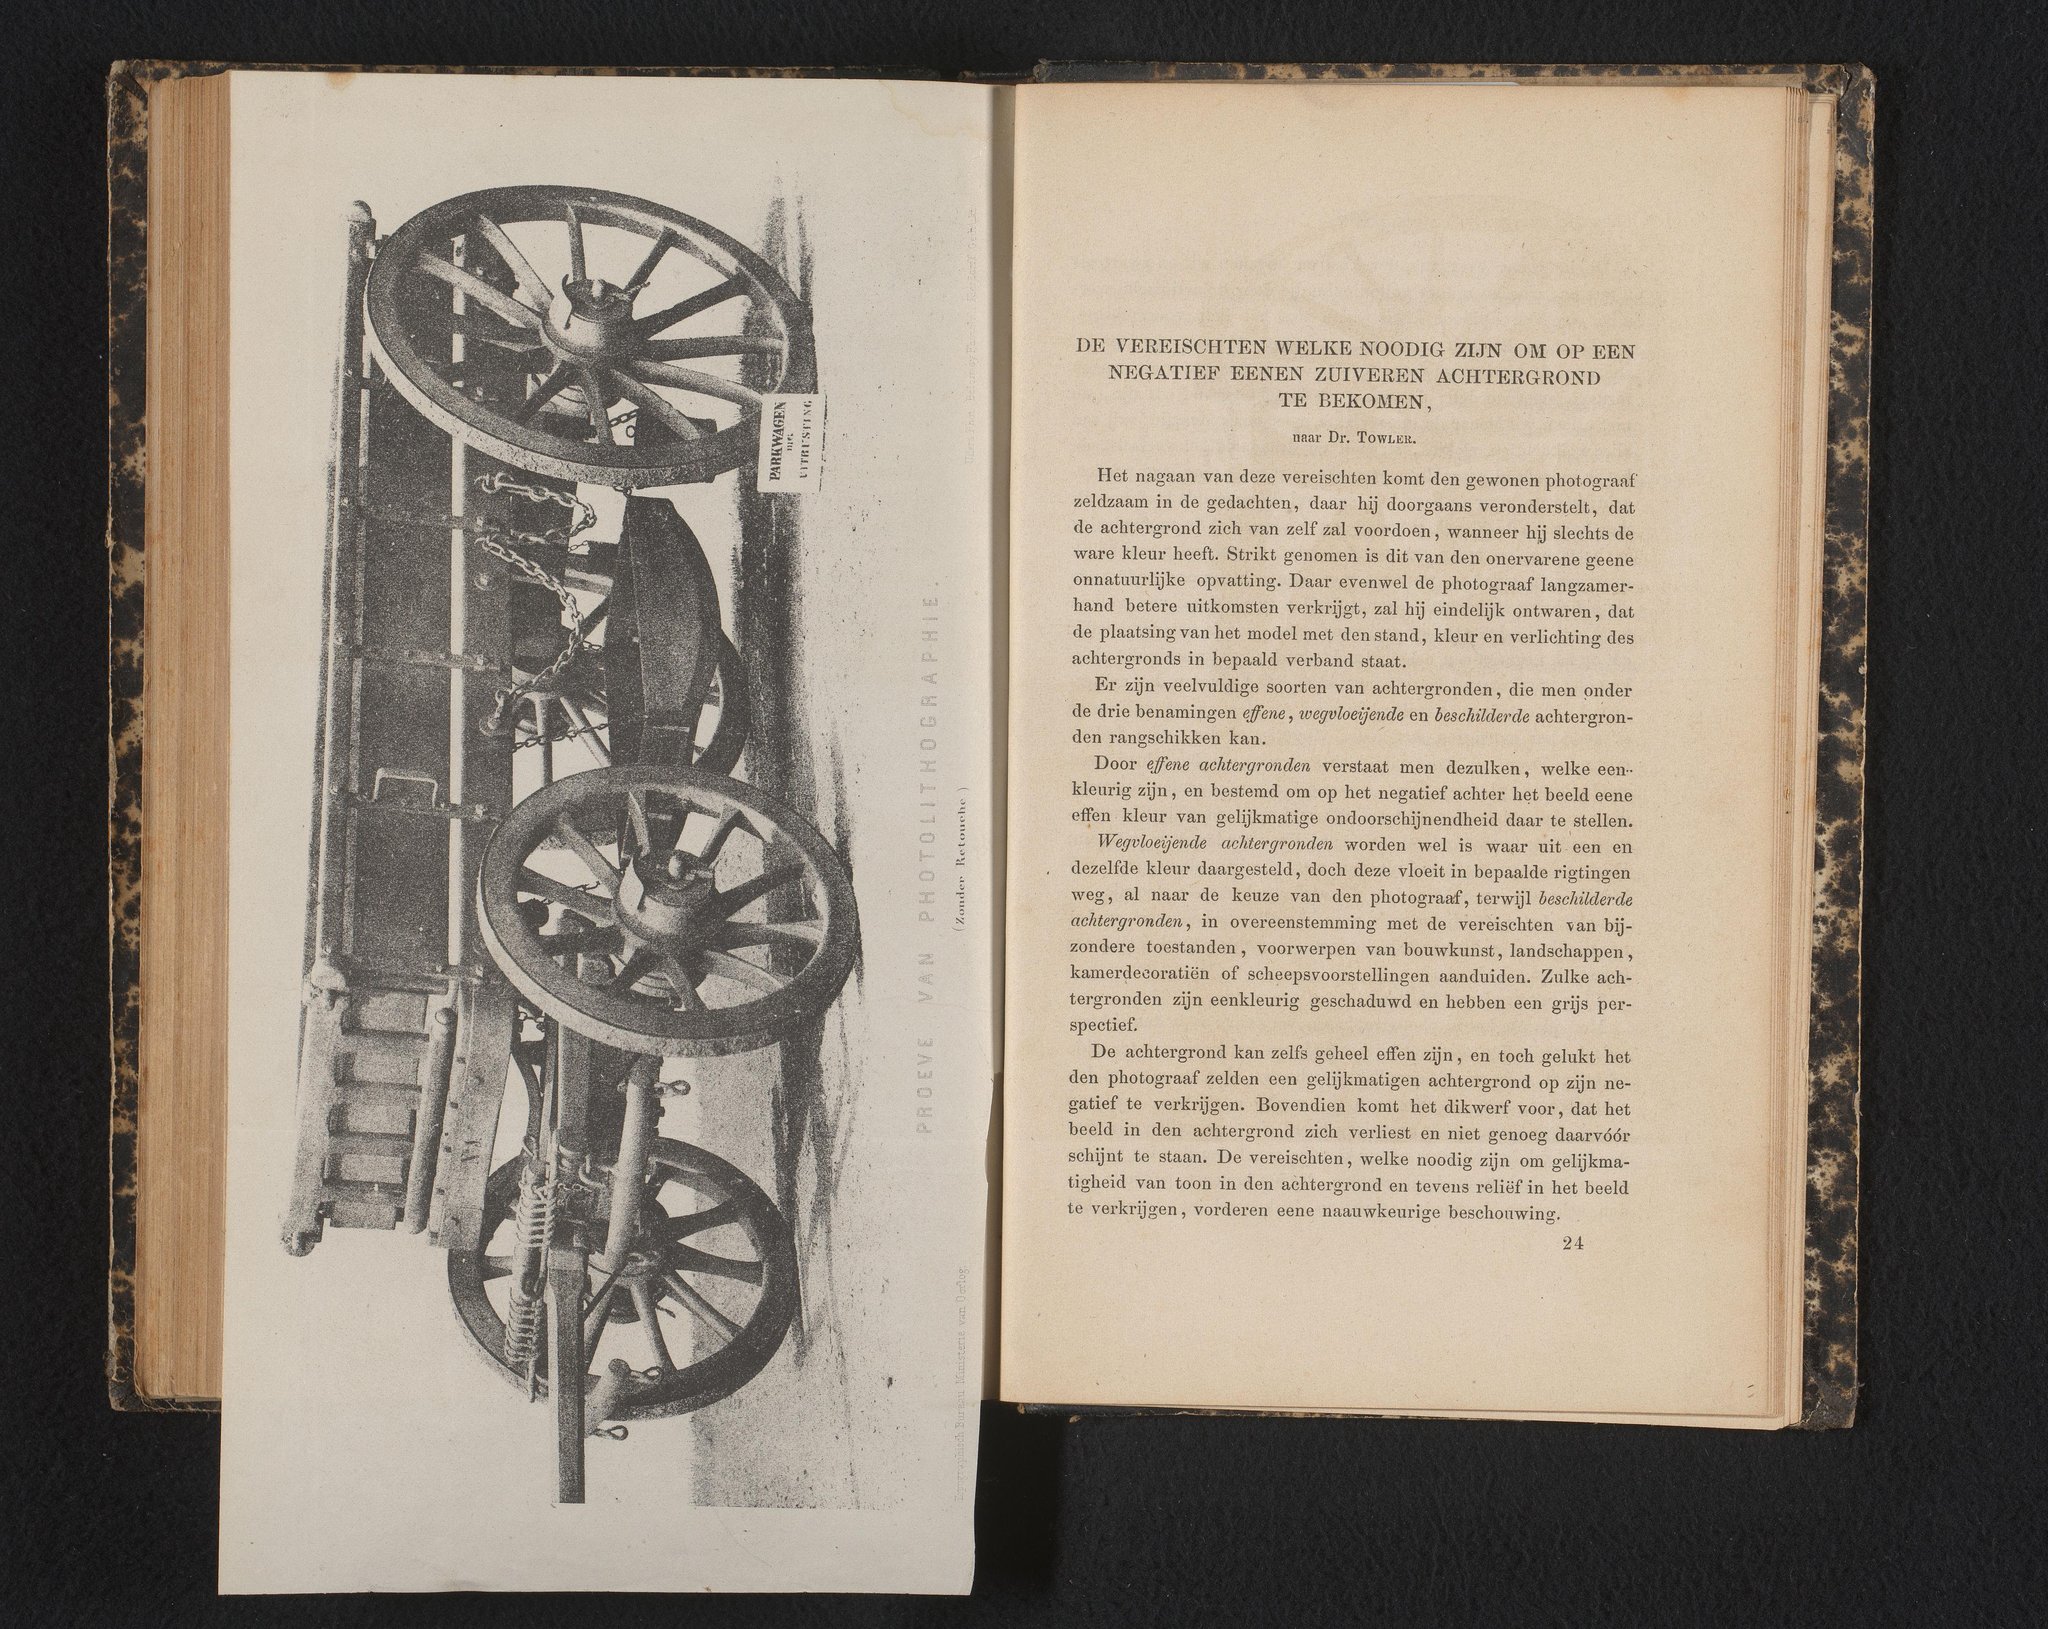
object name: page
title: Parkwagen met uitrusting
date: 1859-1864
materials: paper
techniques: photolithography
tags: four-wheeled, animal-drawn vehicle, e.g.: cab, carriage, coach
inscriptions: inscription: ‘Topographisch Bureau Ministerie van Oorlog.’, inscription: ‘PROEVE VAN PHOTOLITHOGRAPHIE./ (Zonder Retouche)’